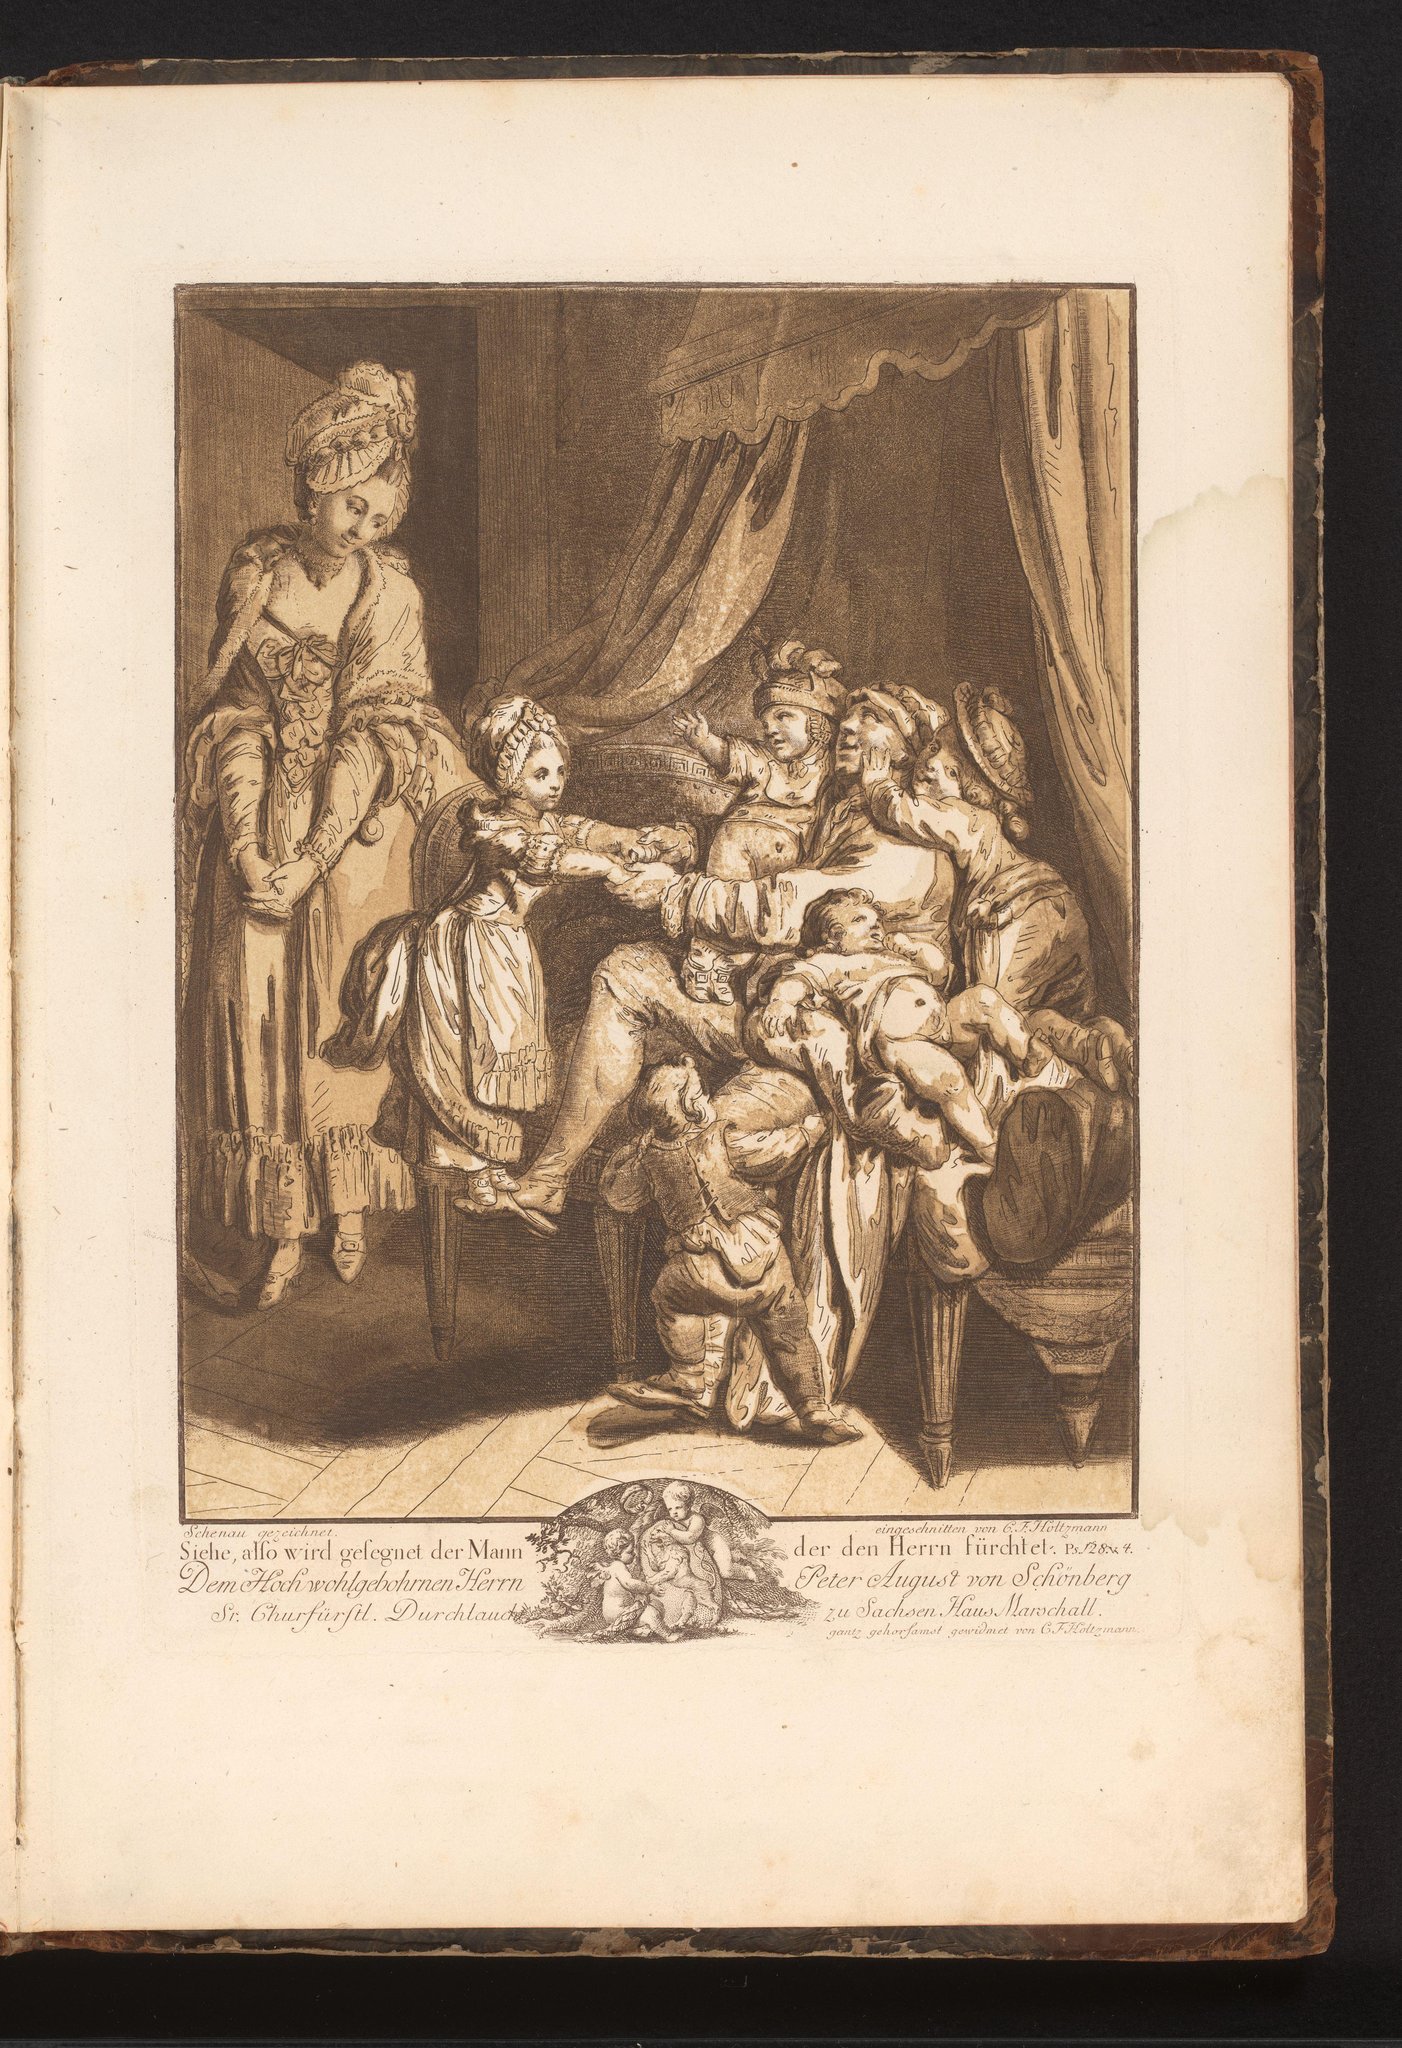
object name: album leaf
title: Man op een bank omringd door vijf kinderen terwijl zijn vrouw naast hem staat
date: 1750-1811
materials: paper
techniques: etching, intaglio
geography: dresden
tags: the book of psalms (with book chapter:verse), family group, especially parents with their child(ren), ornament ~ medallion, cupids: 'amores', 'amoretti', 'putti'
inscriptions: collector's mark: Lugt 2228, collector's mark: Lugt 2760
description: Onder de voorstelling een éénregelige tekst uit Psalm 128:4 en de opdracht in het Duits. Prent maakt deel uit van een album.